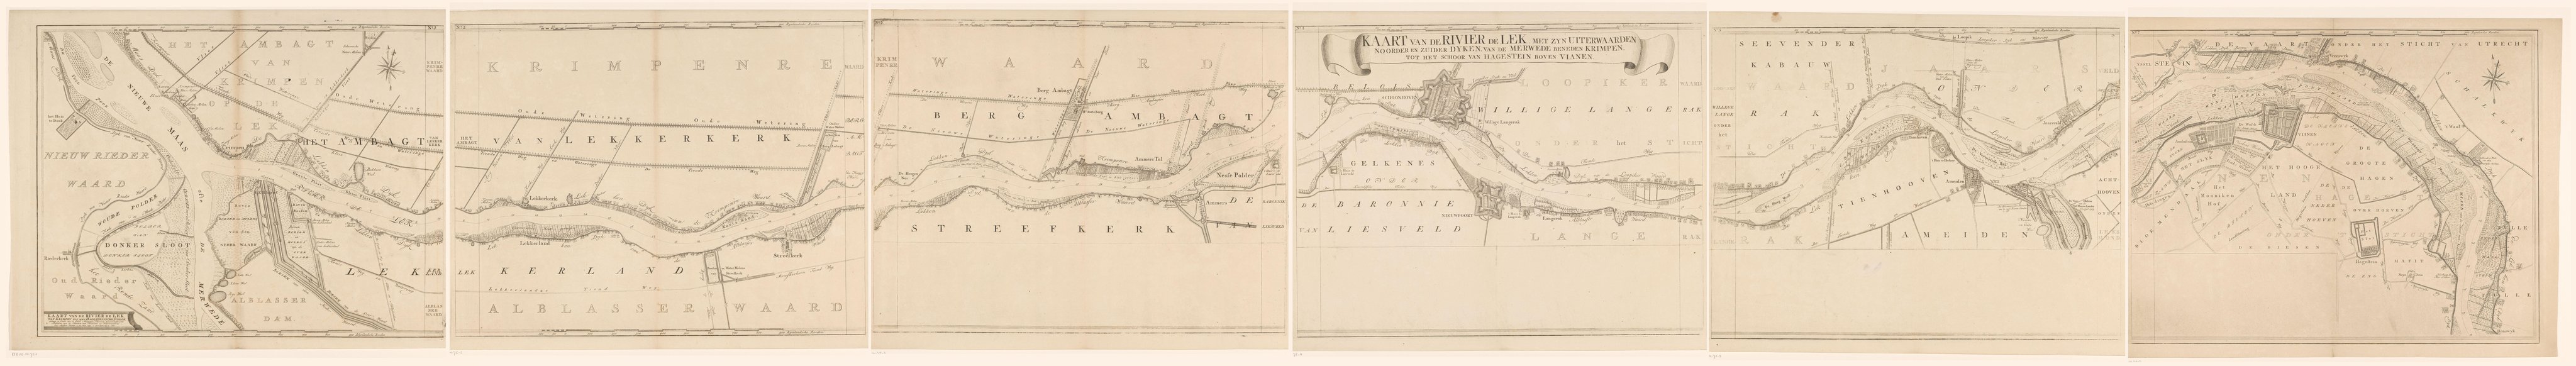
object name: print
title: Kaart van de rivier de Lek, met zyn uiterwaarden noorder en zuider dyken, van de Merwede beneden Krimpen, tot het schoor van Hagestein boven Vianen / Kaart van de rivier de Lek van Krimpen tot het Hagesteinsche Schoor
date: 1764-1765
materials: paper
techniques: engraving, etching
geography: amsterdam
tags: maps of separate countries or regions, river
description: Kaart van de rivier de Lek, van Krimpen aan de Lek tot Hagestein. Linksonder een cartouche met de tweede titel. Rechts daarvan een schaalstok: 900 Rhynlandsche roeden. Deze schaalstok wordt nog zeven keer langs de bovenkant en nog één keer langs de onderkant herhaald. Boven in het midden een banderol met de eerste titel. Langs een groot deel van de onderkant is een blanco cartouche te zien, bedoeld voor grafieken met gepeilde rivierdieptes. Waarschijnlijk is dit wegens tijdgebrek niet afgemaakt.